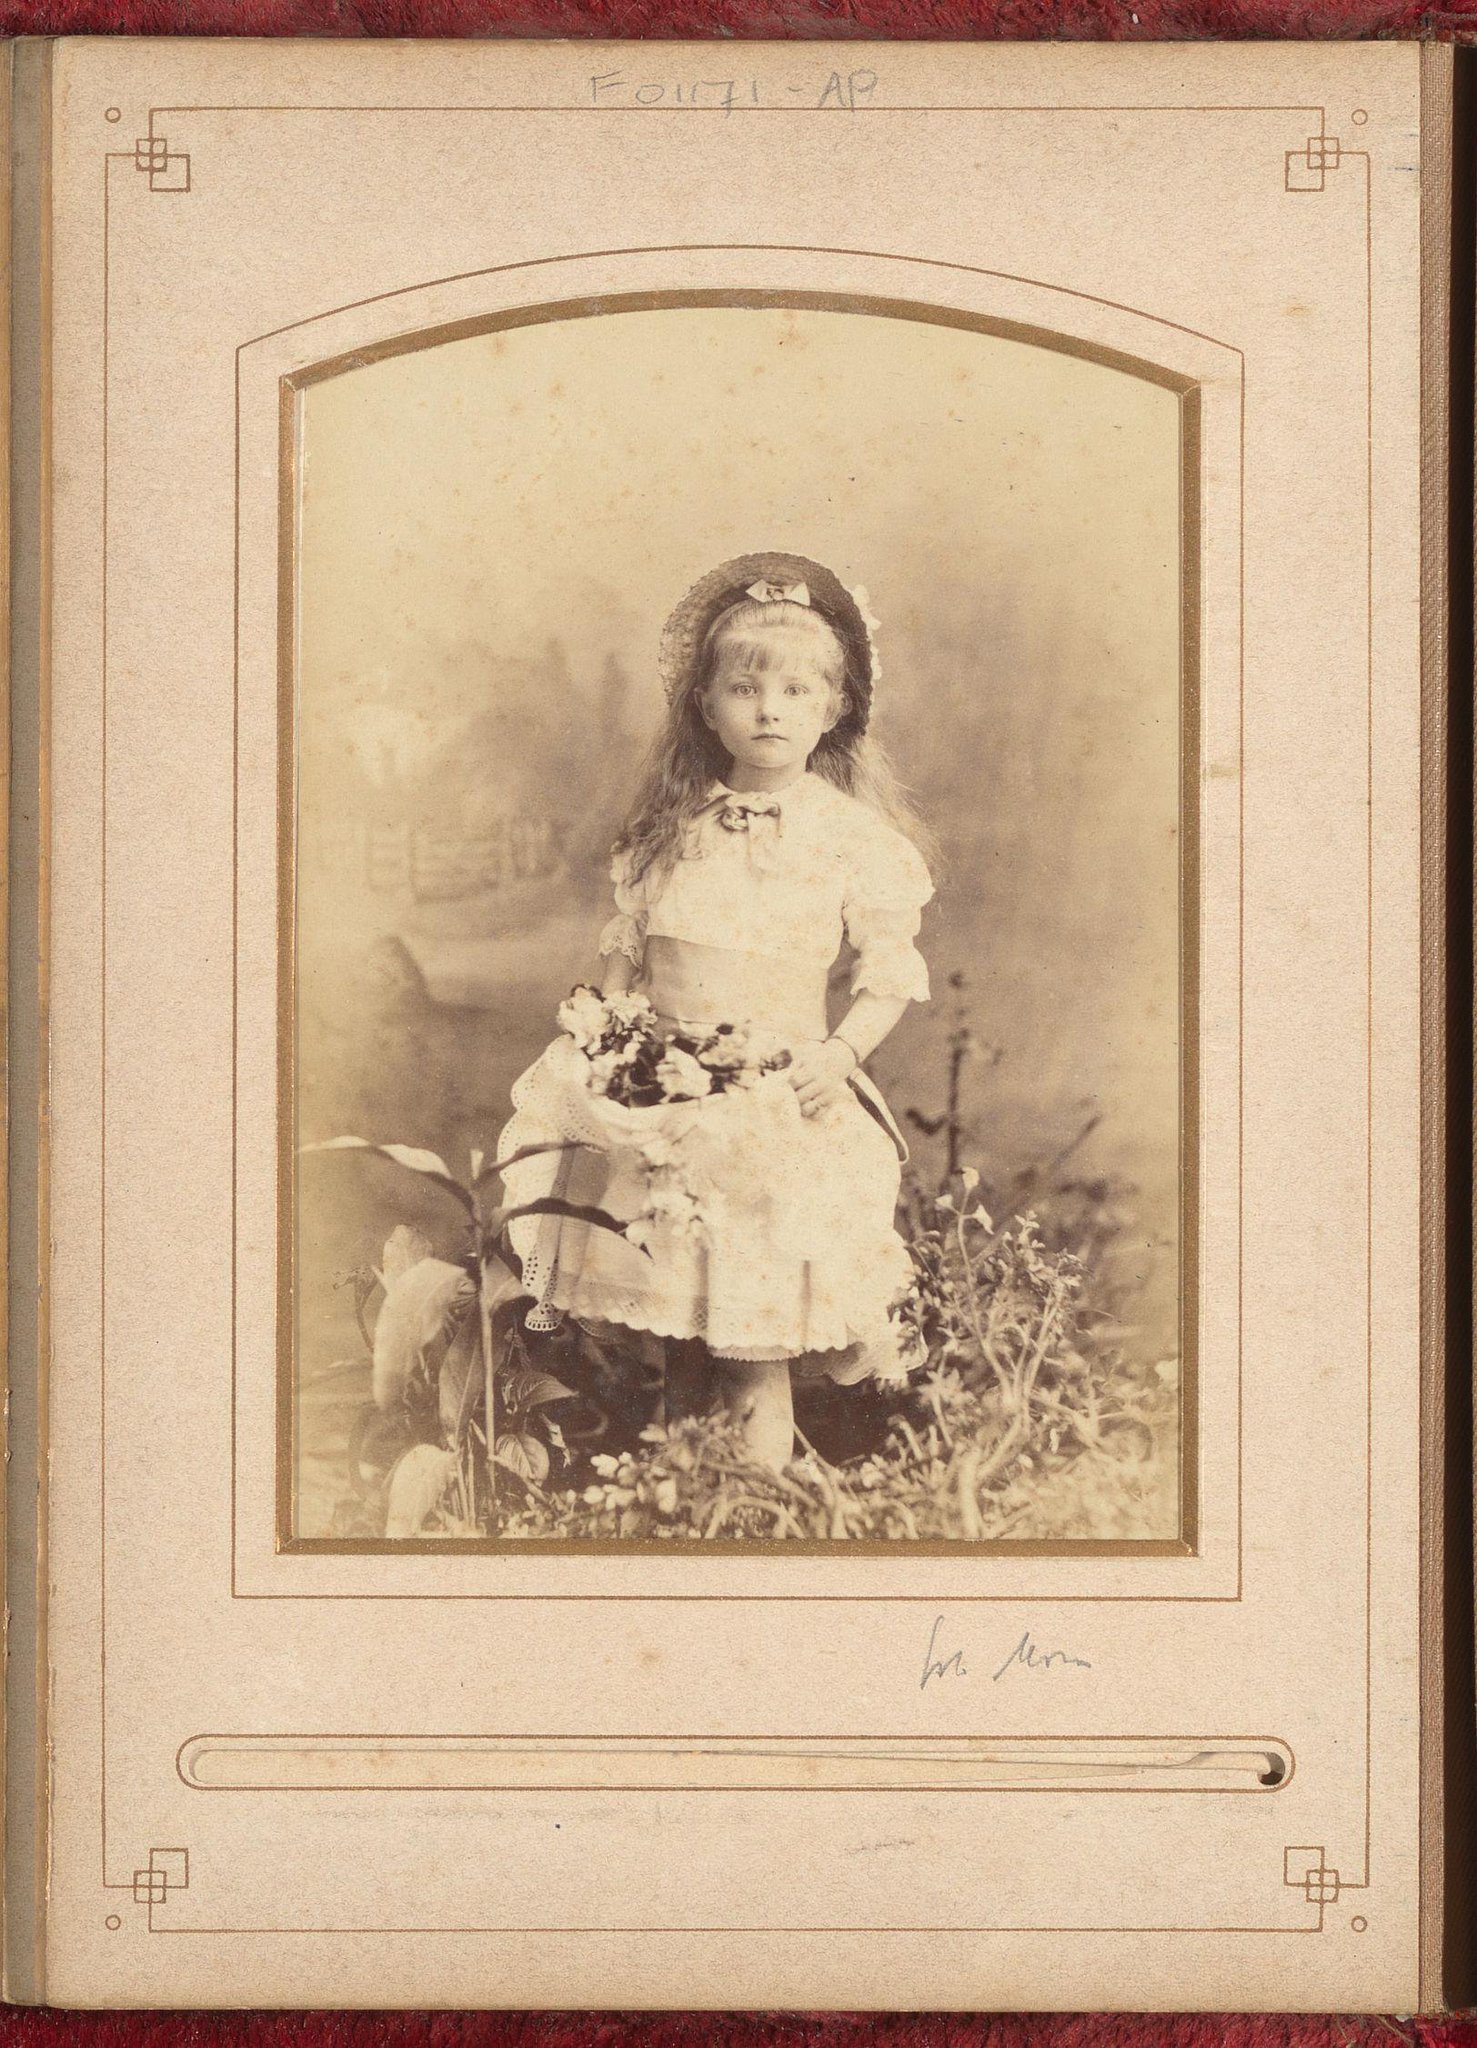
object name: cabinet photograph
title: Portret van een meisje met bloemen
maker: josé maria mora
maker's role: fotograaf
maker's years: 1849-1926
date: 1870-1900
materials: cardboard, photographic support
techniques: albumen print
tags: girl (child between toddler and youth)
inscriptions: number: ‘120/ 877/ 53’, retailer's mark: ‘Jacs Rookmaaker/ Boek- & Kunsthanel/ Haarlem’, name: ‘Mora 707 Broadway N.Y.’